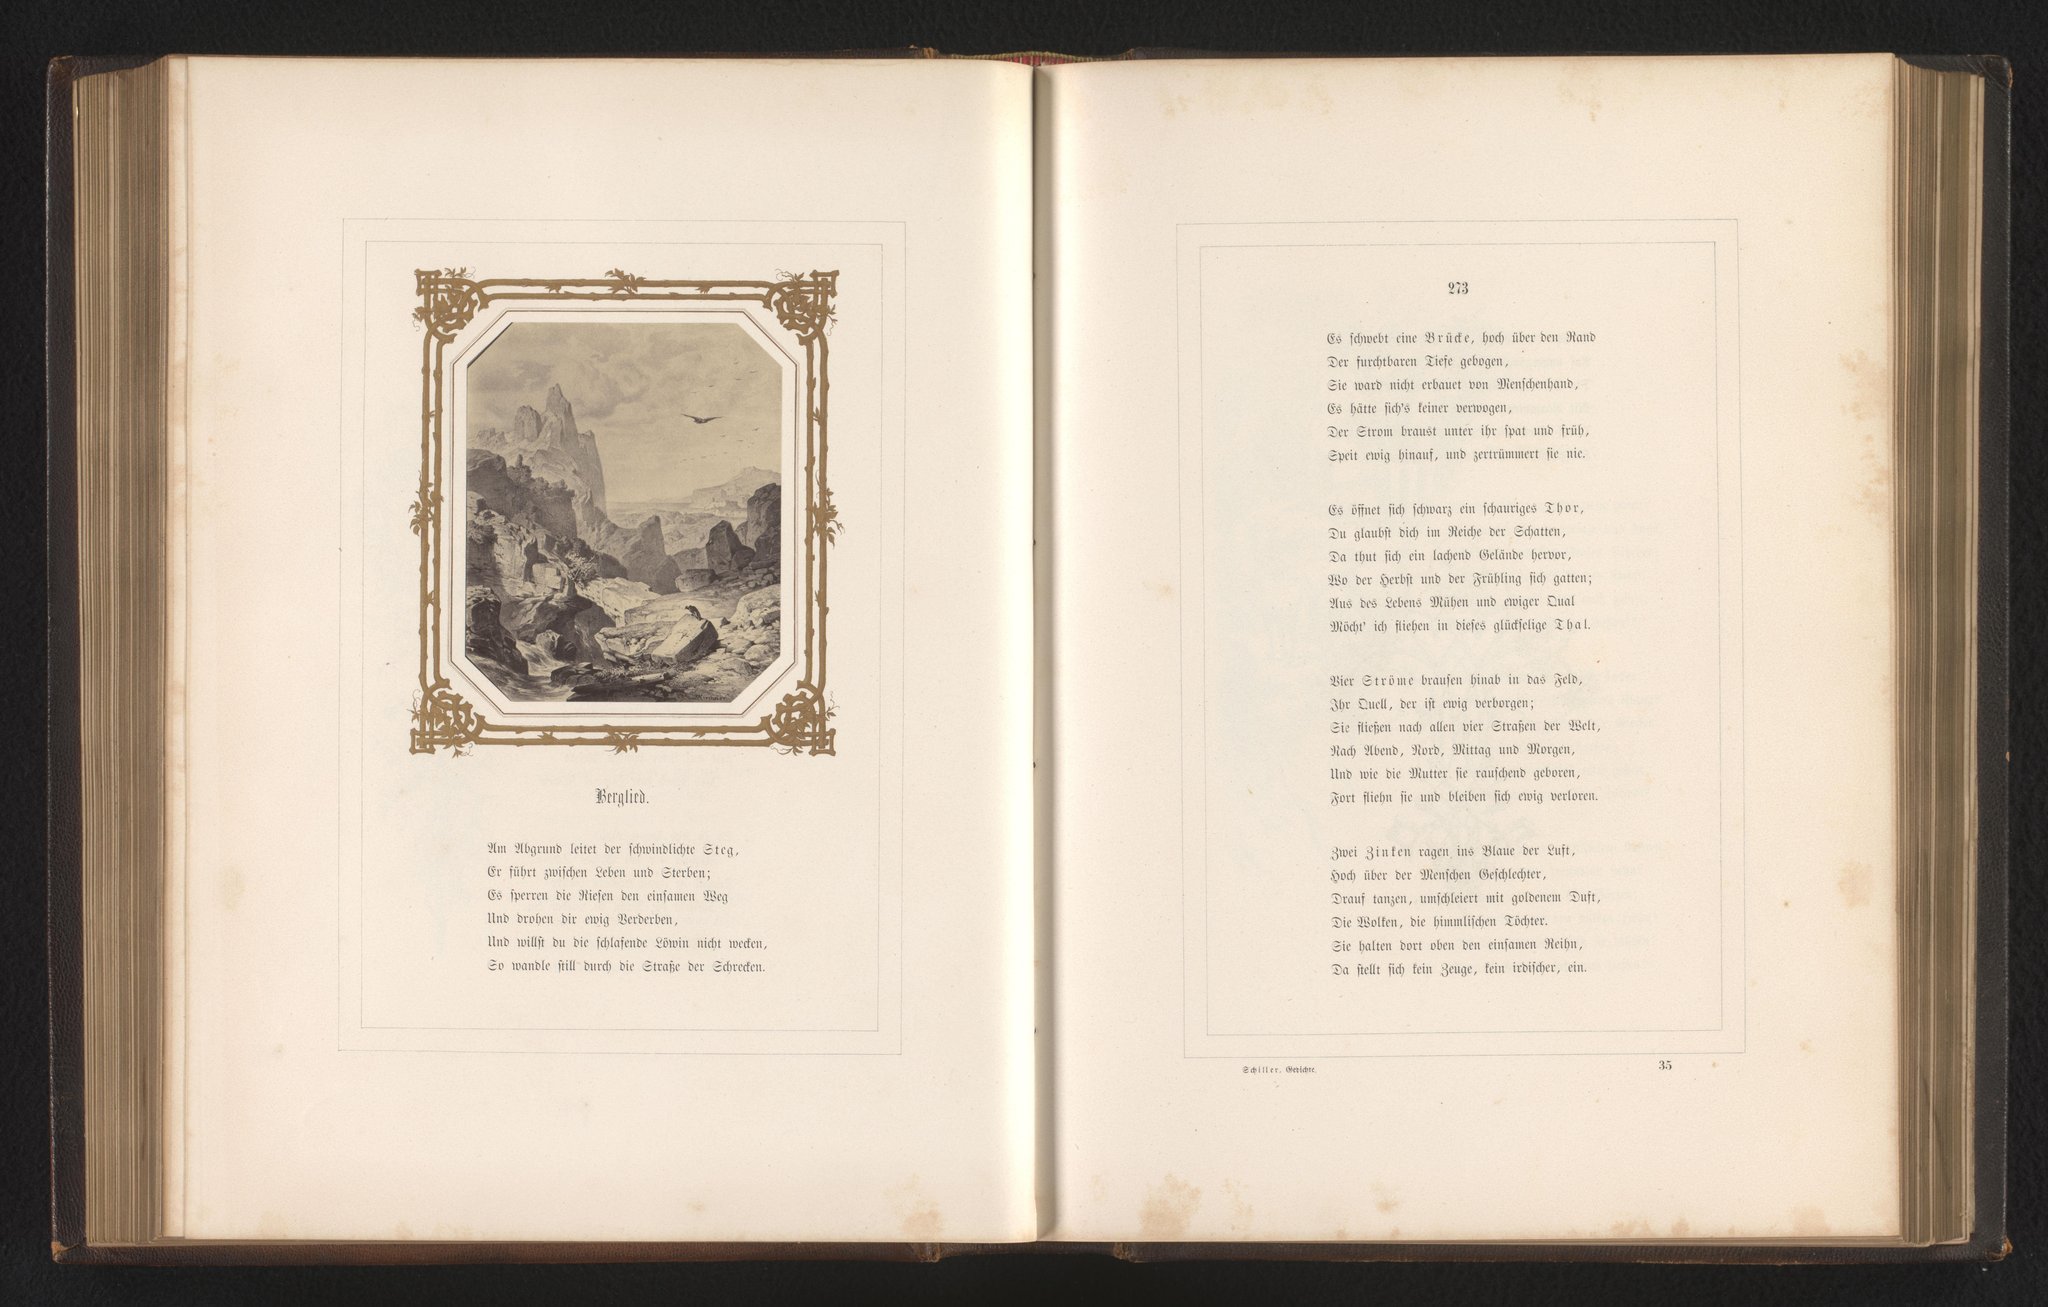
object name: page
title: Fotoreproductie van een tekening van een berglandschap door Albert Emil Kirchner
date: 1855-1862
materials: paper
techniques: albumen print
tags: mountains - hh - ideal landscapes